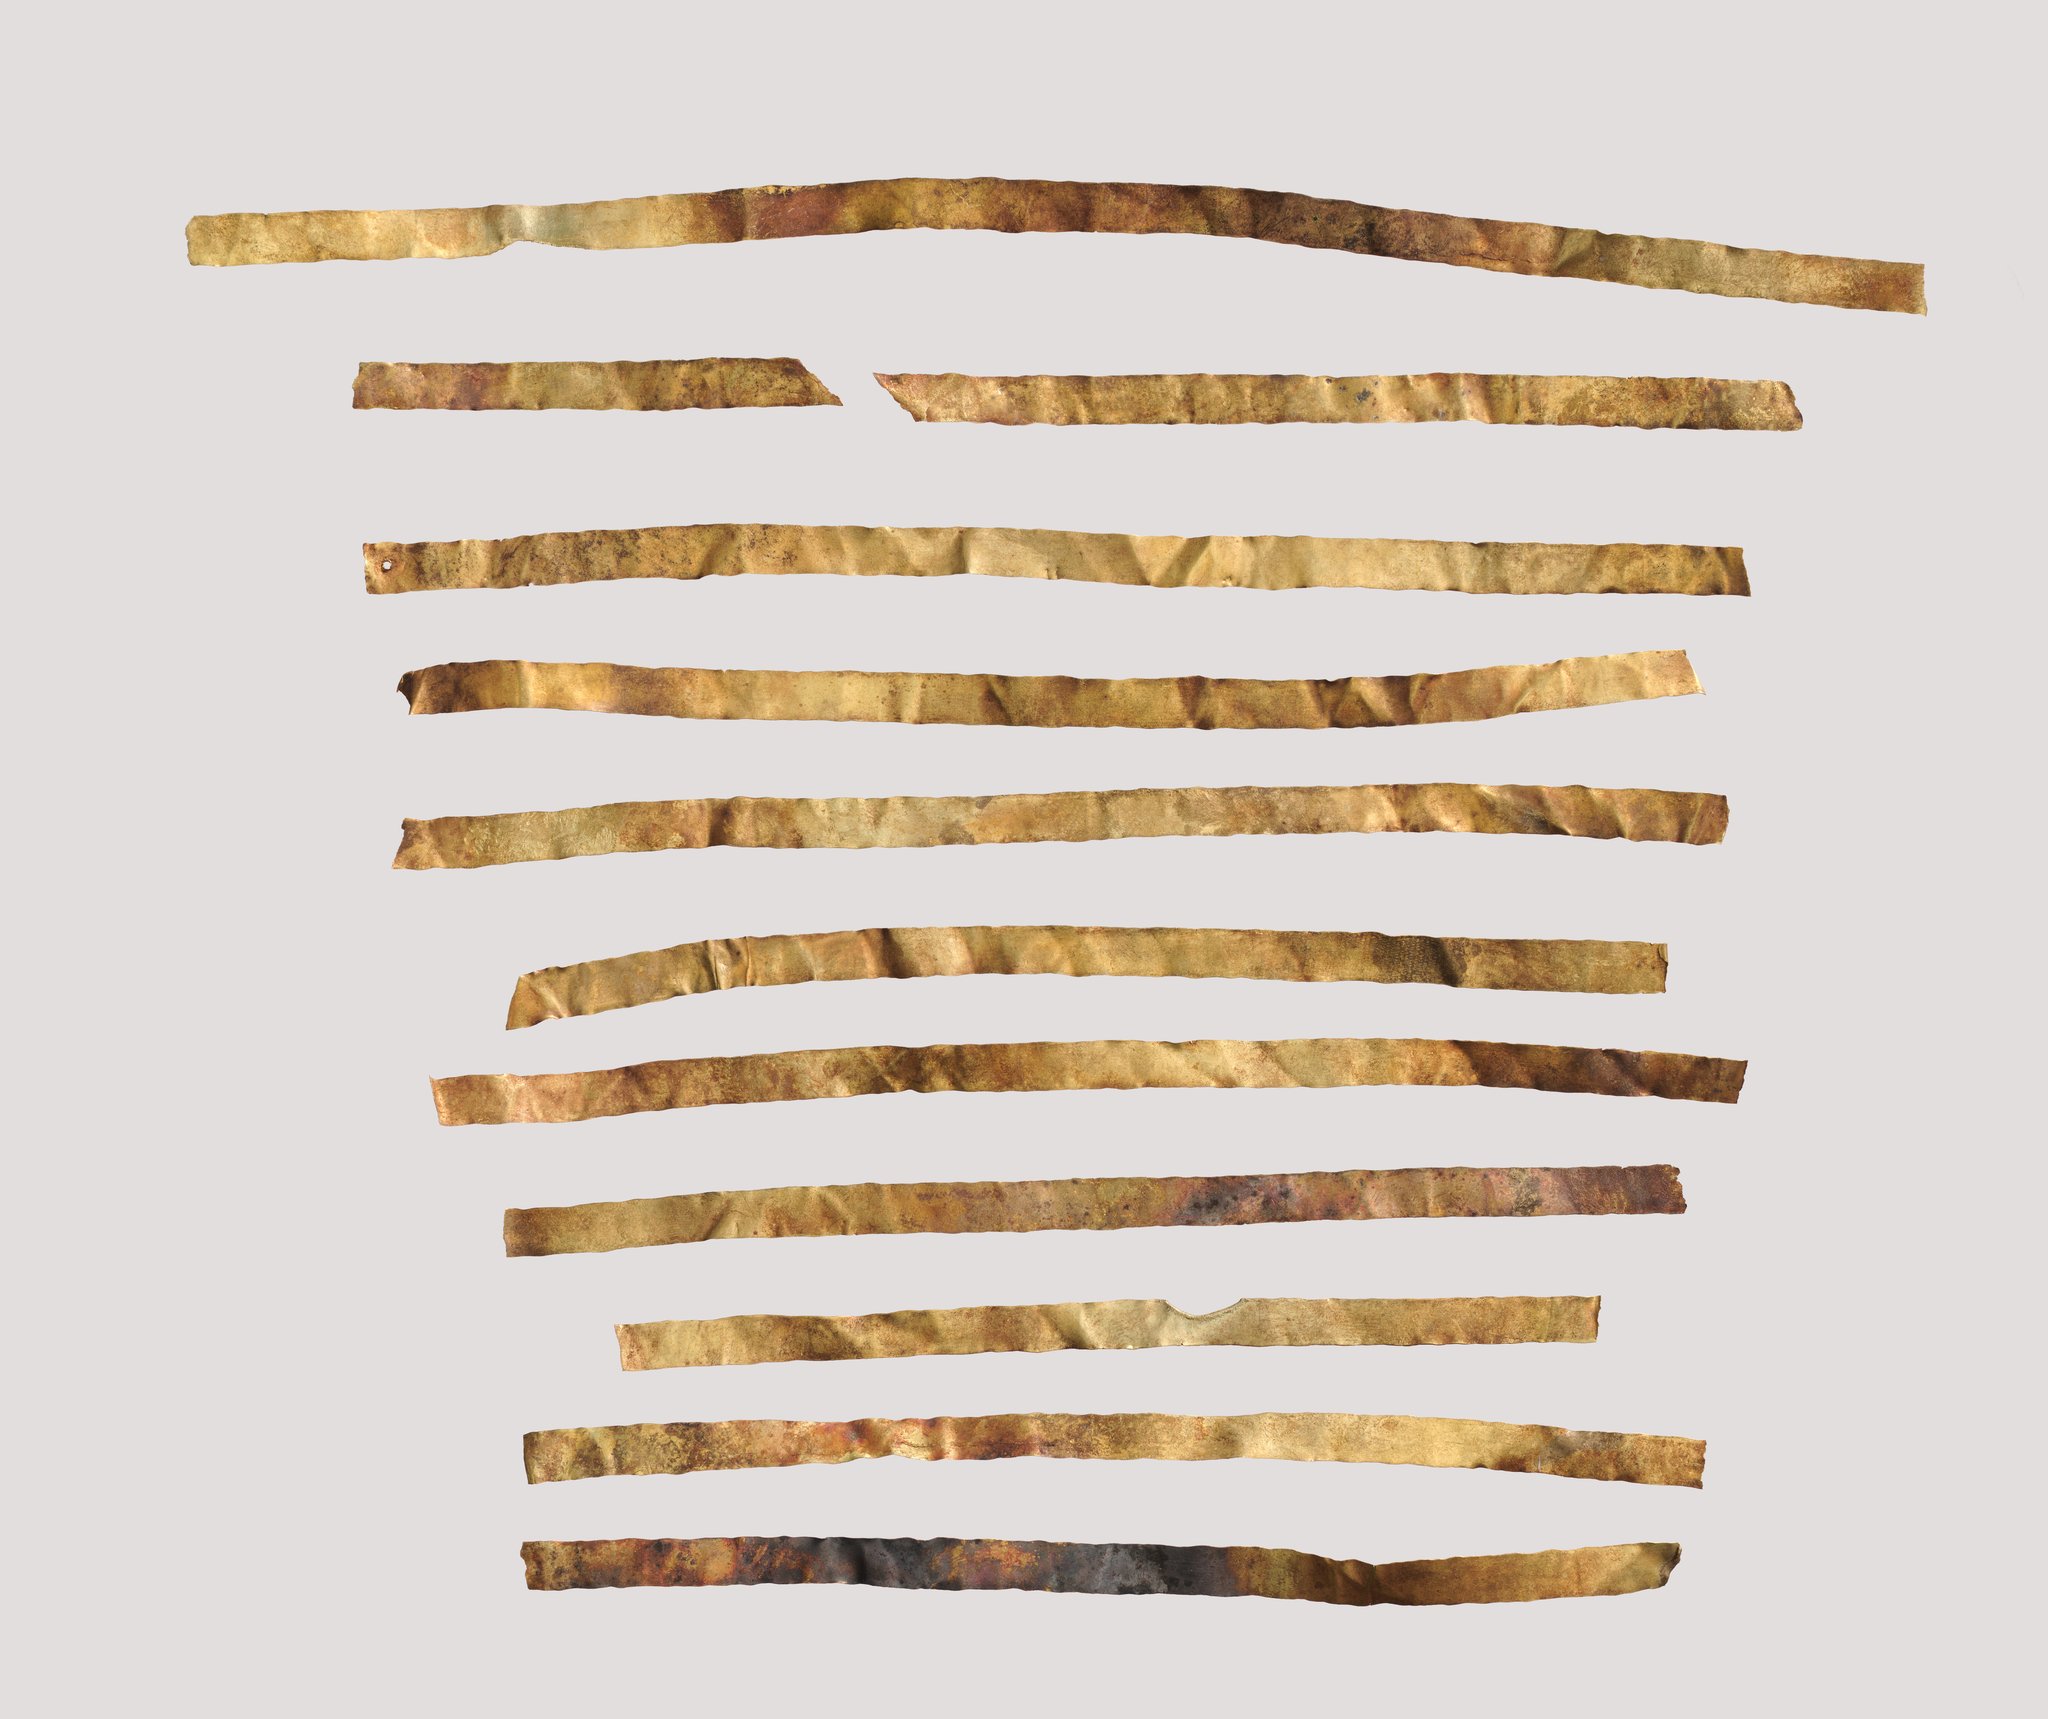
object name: hair ribbon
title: Hair ribbons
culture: sumerian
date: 2600-2500 BCE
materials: gold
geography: mesopotamia